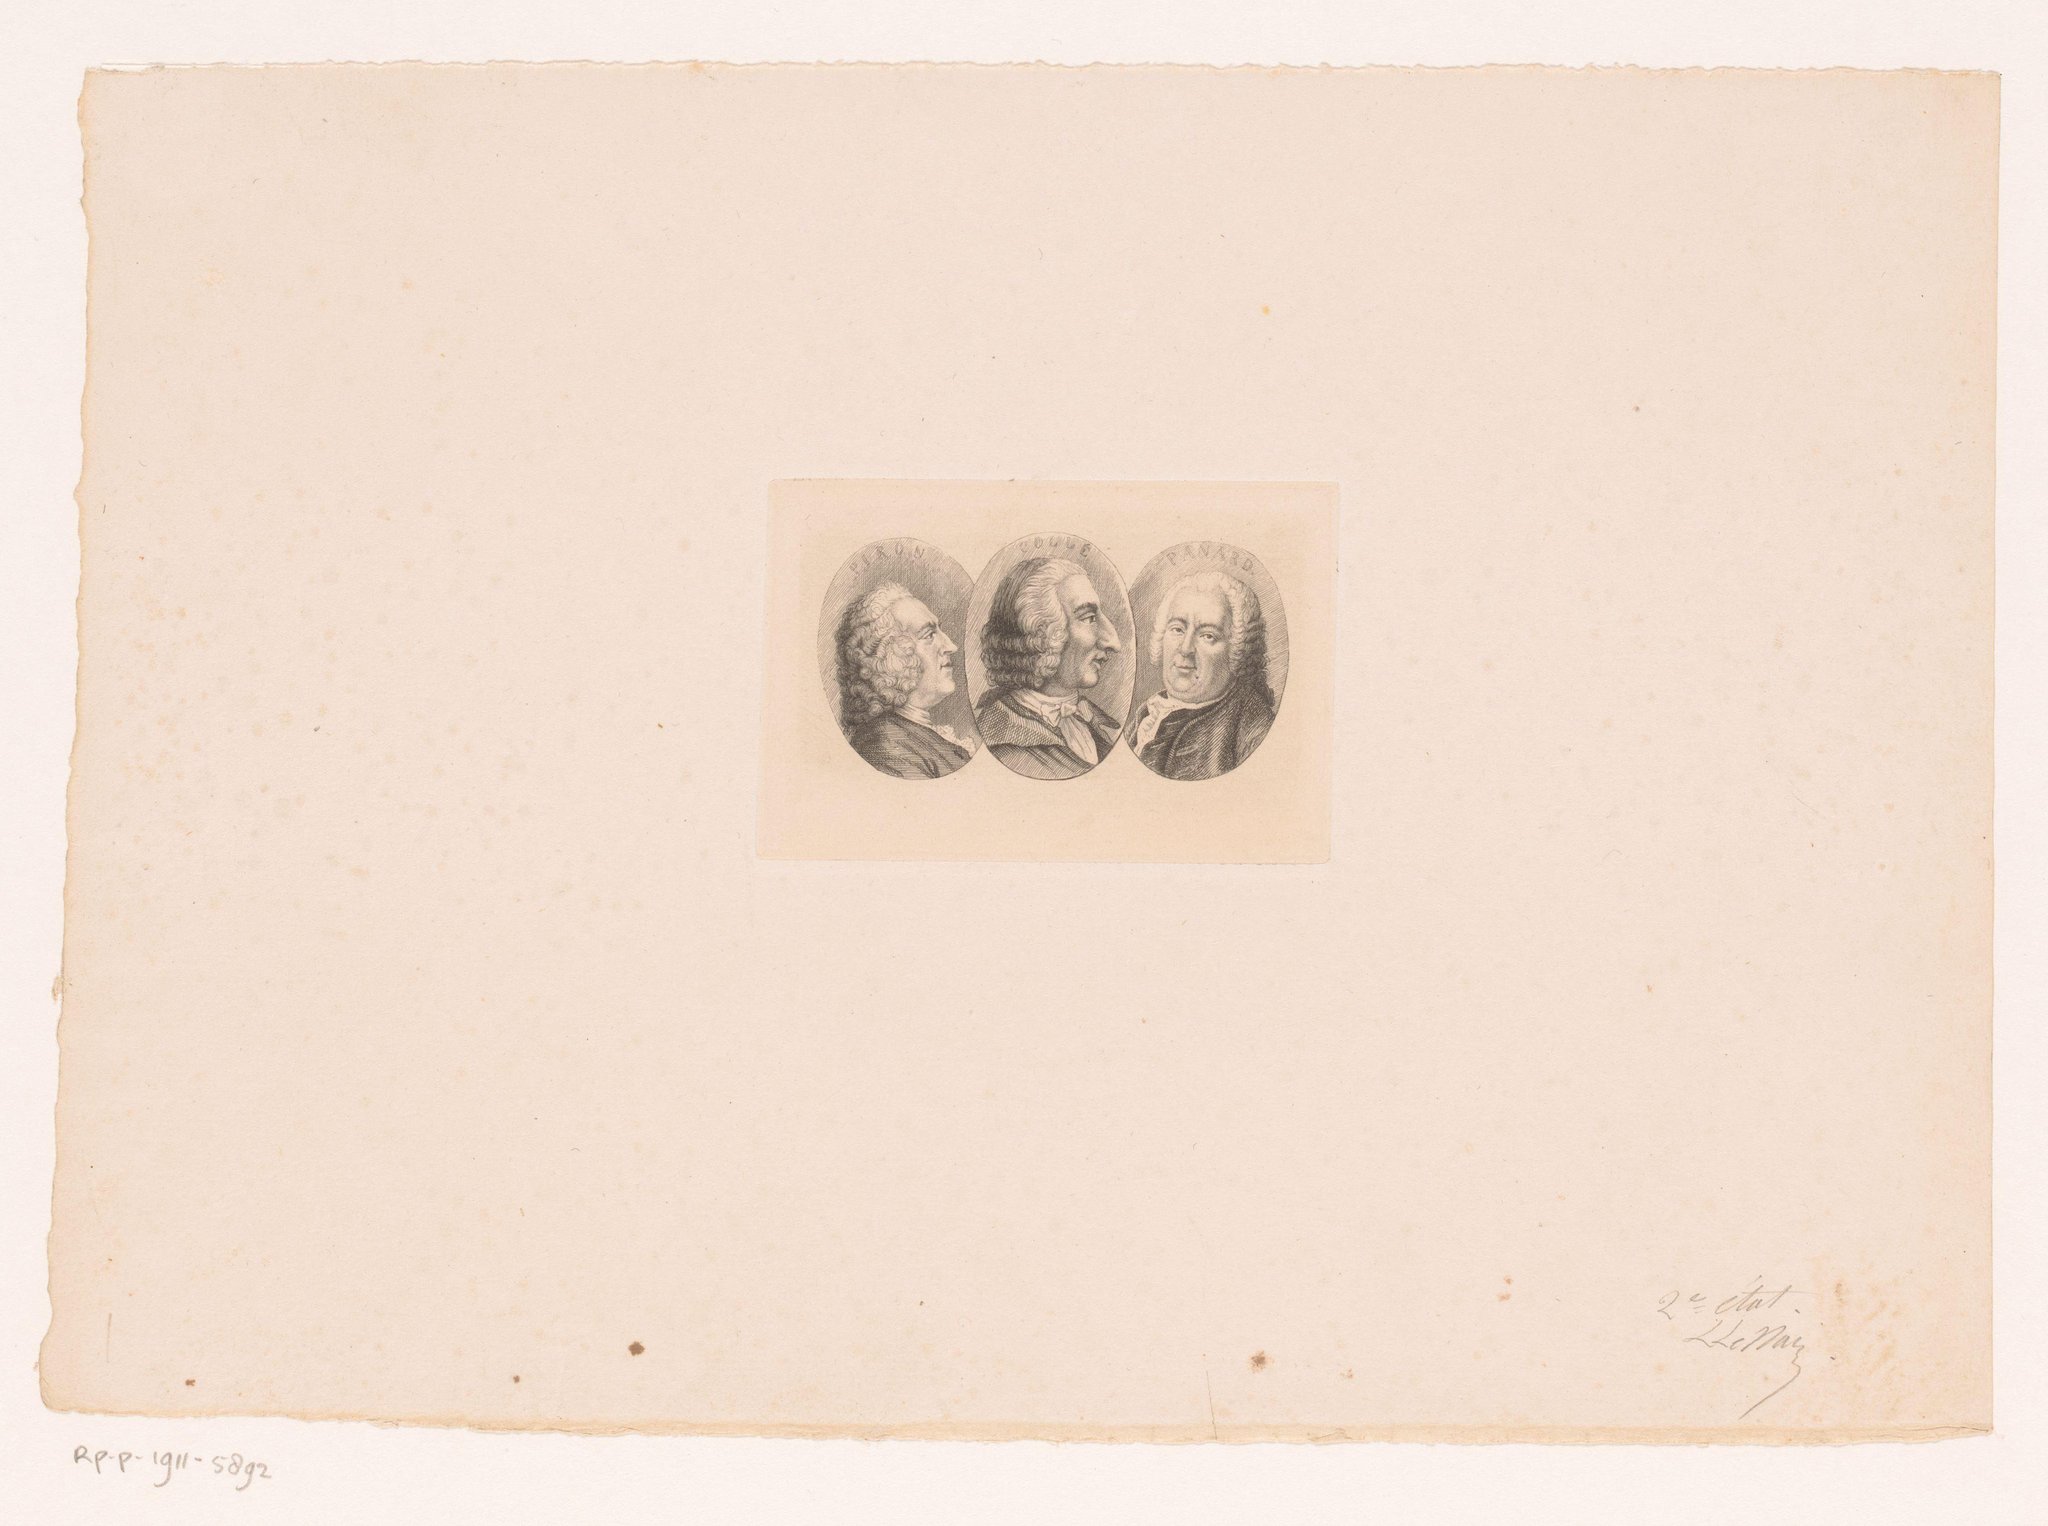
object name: print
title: Drie medaillons met de portretten van Alexis Piron, Charles Collé en Charles-Francois Pannard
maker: louis le nain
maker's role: print maker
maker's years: 1851-1939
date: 1861-1911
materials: paper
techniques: etching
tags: charles-francois pannard, adult man, historical persons, writer, poet, author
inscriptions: collector's mark: Lugt 2228, inscription: ‘2e état LLeNain’